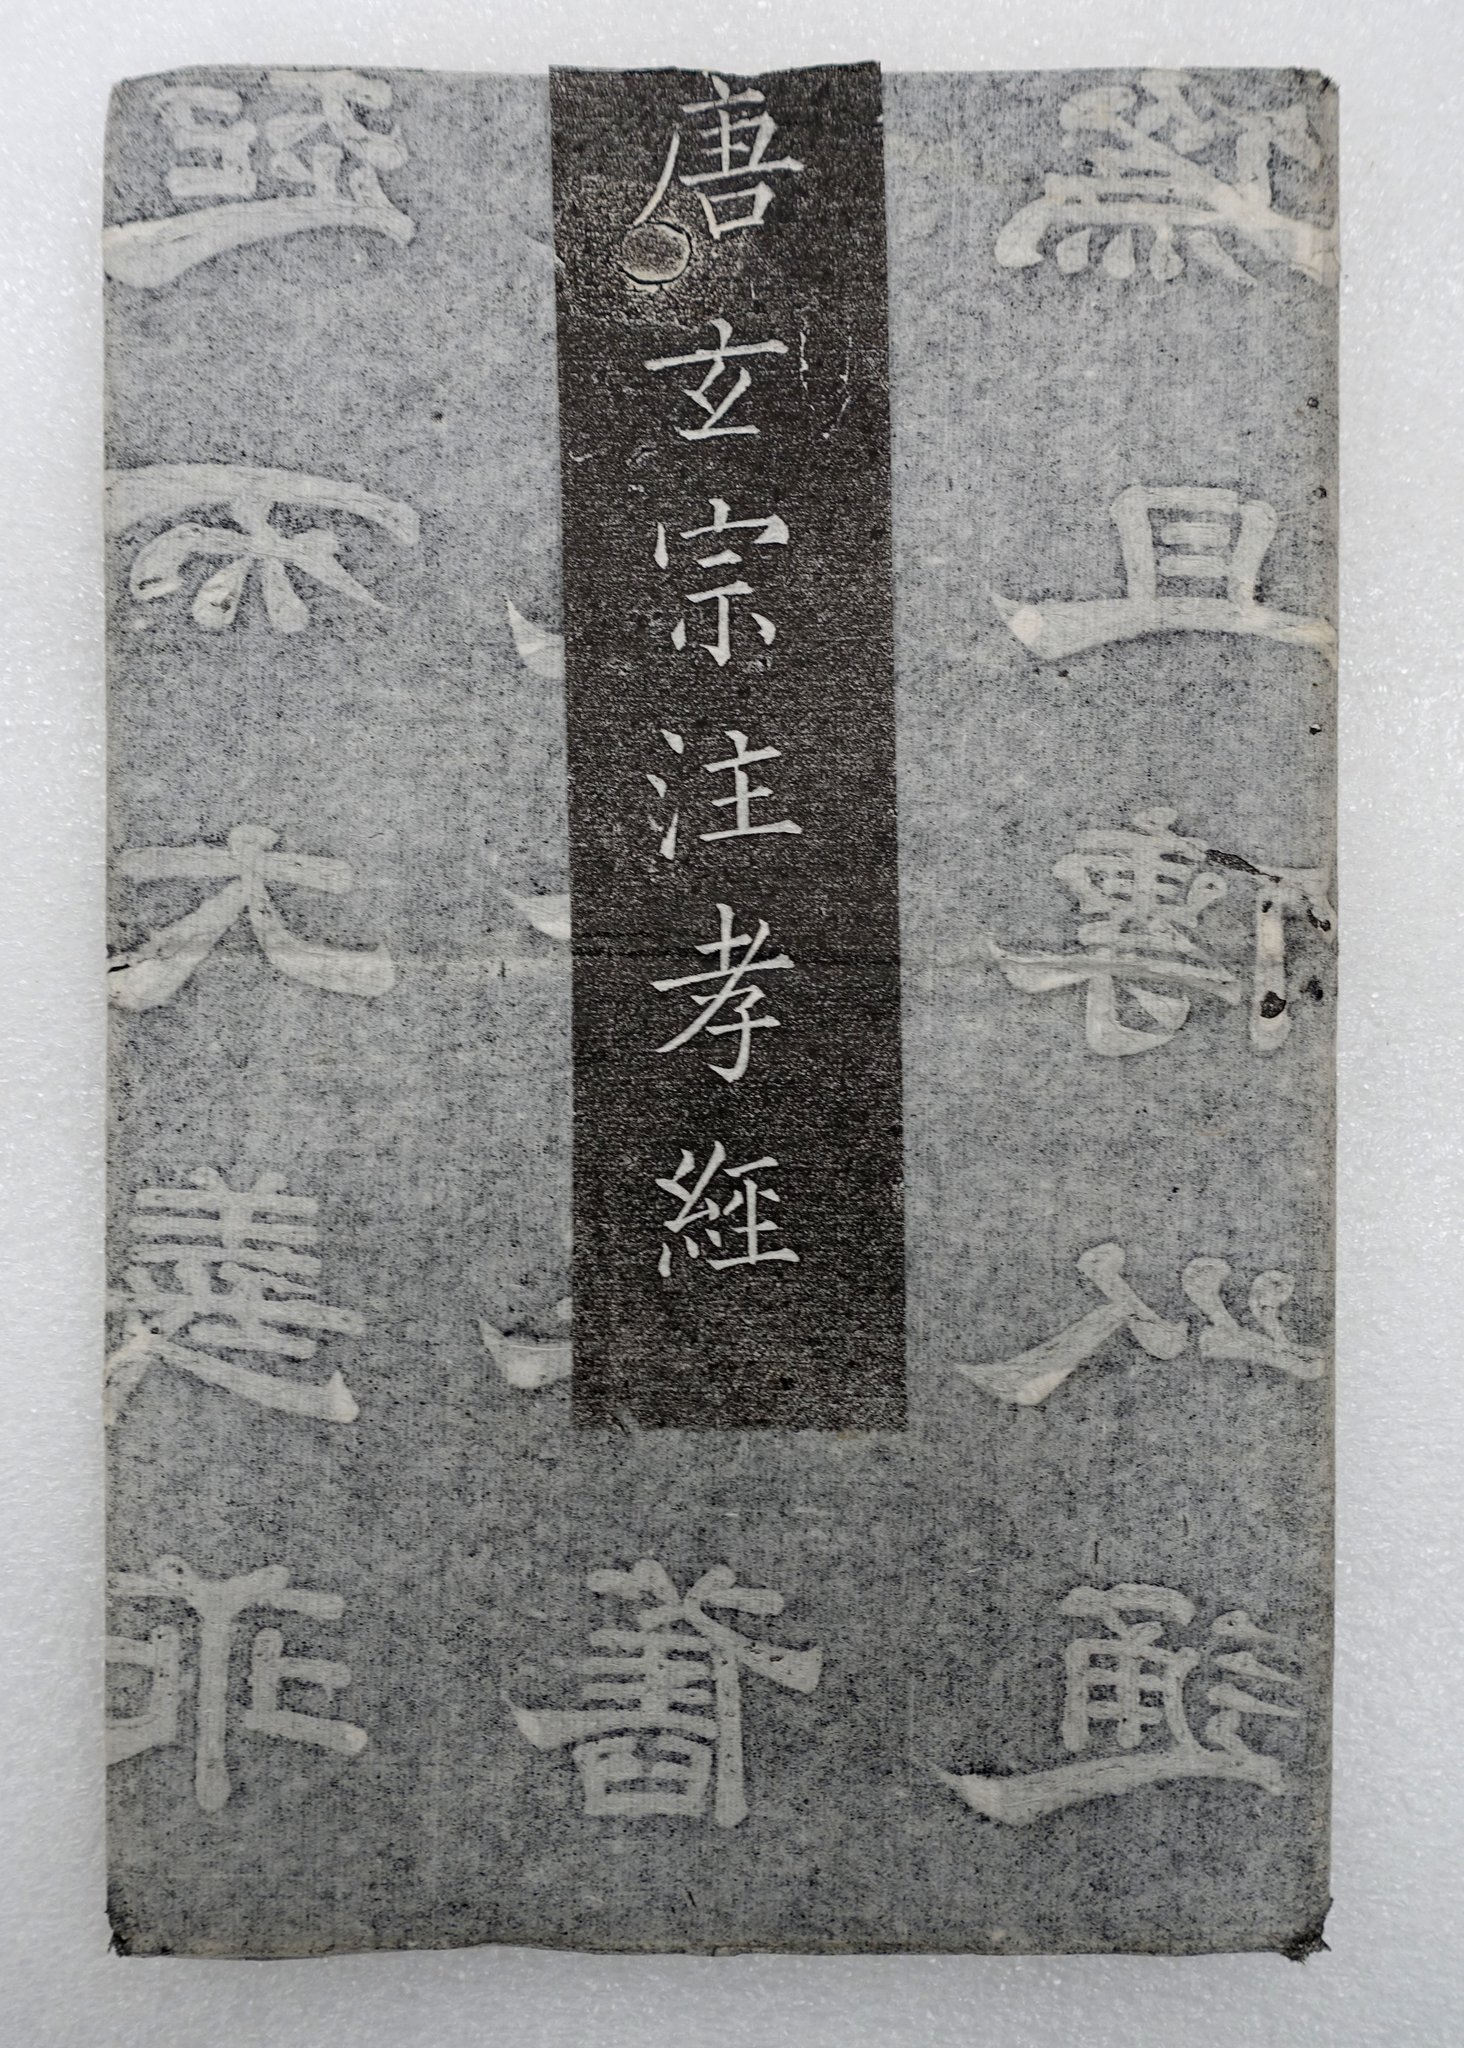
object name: rubbing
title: Xuanzong's Preface, Text, and Commentary on the Classic of Filial Piety, also known as Shitai Xiaojing (Stone Platform Classic of Filial Piety)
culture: chinese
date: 1901-2000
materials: ink, paper